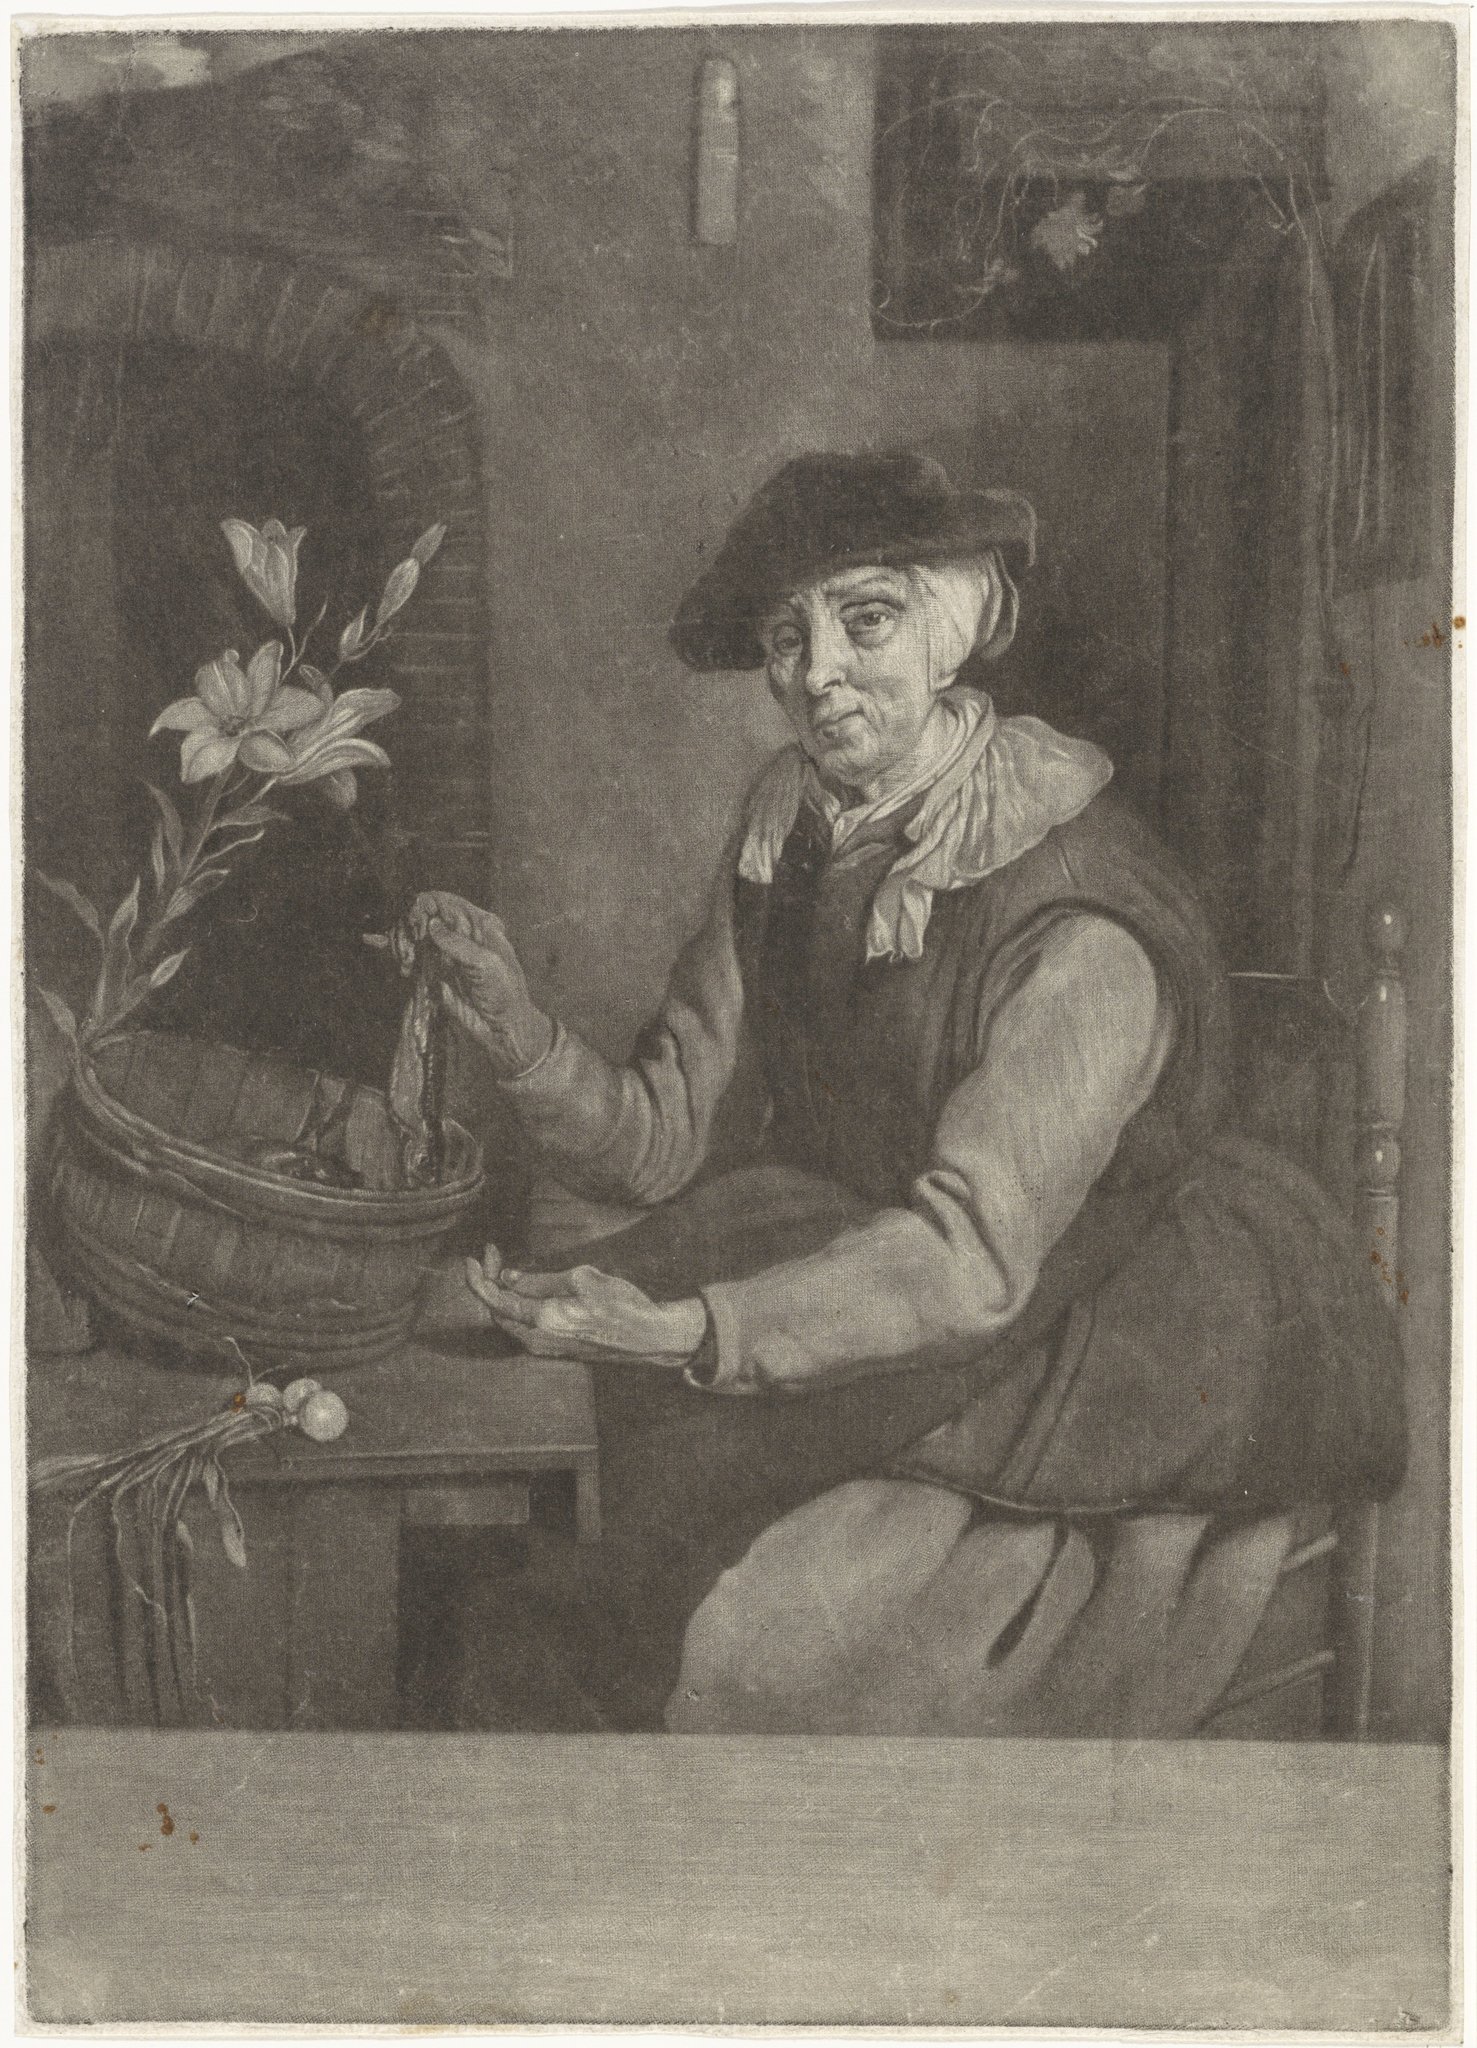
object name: print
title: Oude vrouw met een haring in de hand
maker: dirk koedijck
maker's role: print maker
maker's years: 1681-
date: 1731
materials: paper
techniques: mezzotint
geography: zaandam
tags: bony fishes: herring, old woman, (non-fruit) products of plants or trees: onion, flowers: lily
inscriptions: inscription: ‘[...] gemaakt’, collector's mark: Lugt 2165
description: Een oude vrouw zit in de buitenlucht aan een tafel en houdt een haring in de hand. Op de tafel staat een houten bak met haringen en ligt een bosje uien.